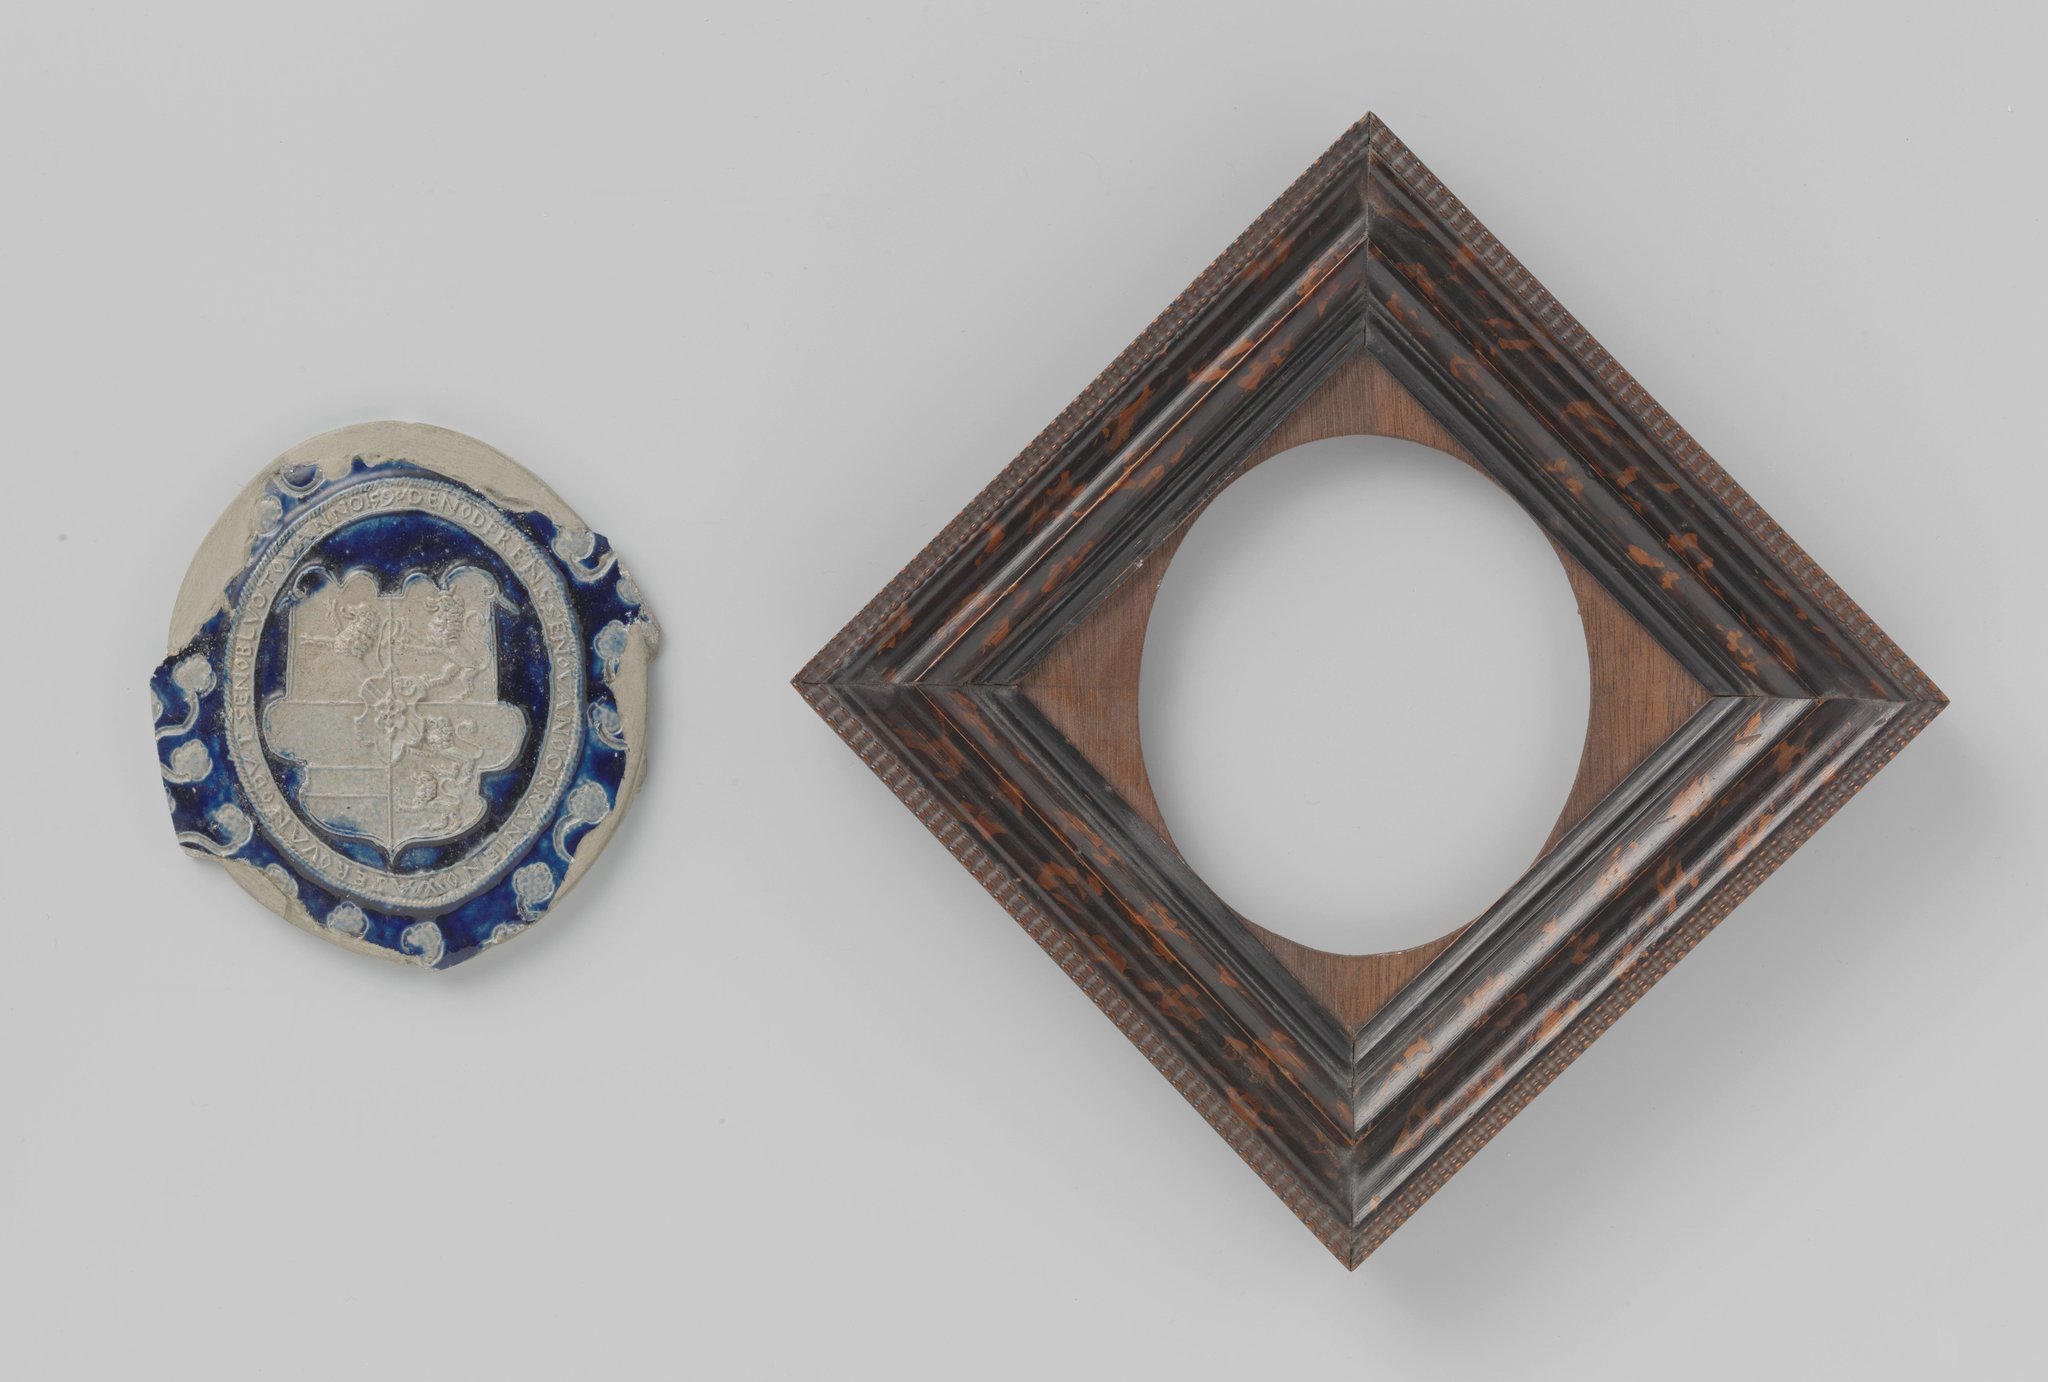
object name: frame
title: Frame for a fragment of stoneware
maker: Anonymous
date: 1800-1999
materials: wood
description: Lijst behorende bij scherf van steengoed met nummer BK-14712-1.